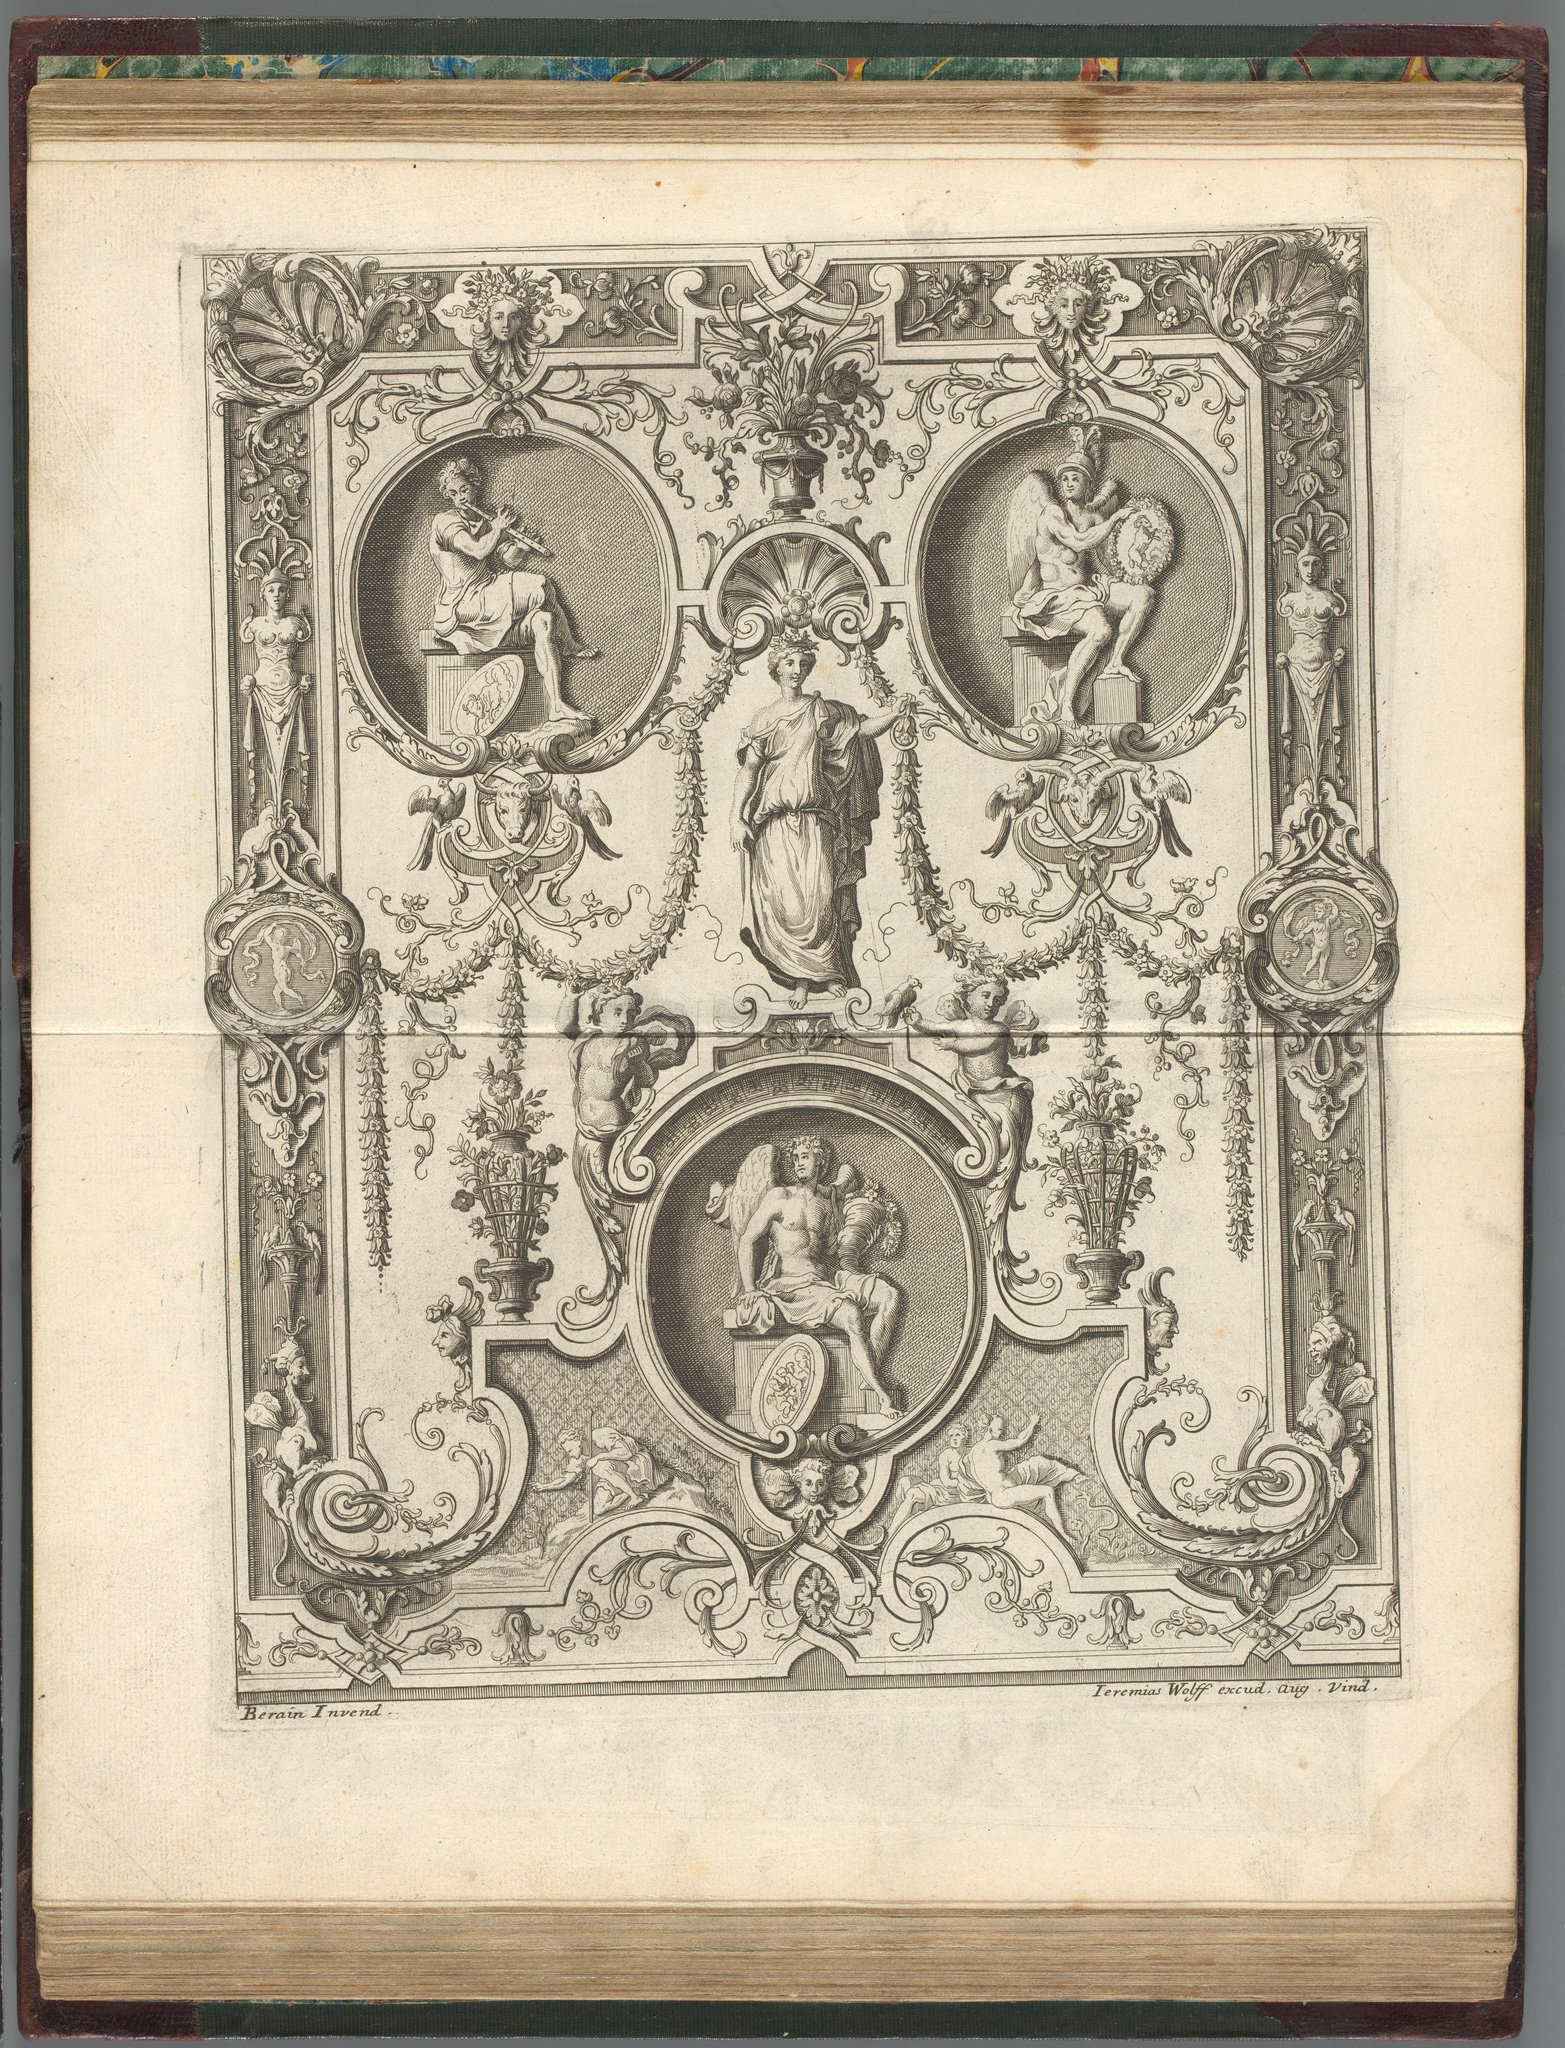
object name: ornament print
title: Lente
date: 1686-1724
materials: paper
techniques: etching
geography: augsburg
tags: 'cornucopia', horn of plenty, ornaments ~ art, spring, 'ver'; 'primavera' (ripa), ornament ~ medallion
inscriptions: signature: ‘Ieremias Wolff excud. Aug. Vind.’, signature: ‘Berain Invend.’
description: Allegorische voorstelling van de lente. Een decoratieve compositie met drie medaillons met personificaties van de maanden maart, april en mei met bijbehorende tekens van de dierenriem. In het midden staat de allegorische figuur van de lente omringd met guirlandes en bloemenvazen. Prent maakt deel uit van een album. Hoogstwaarschijnlijk gespiegelde kopie naar Frans origineel.